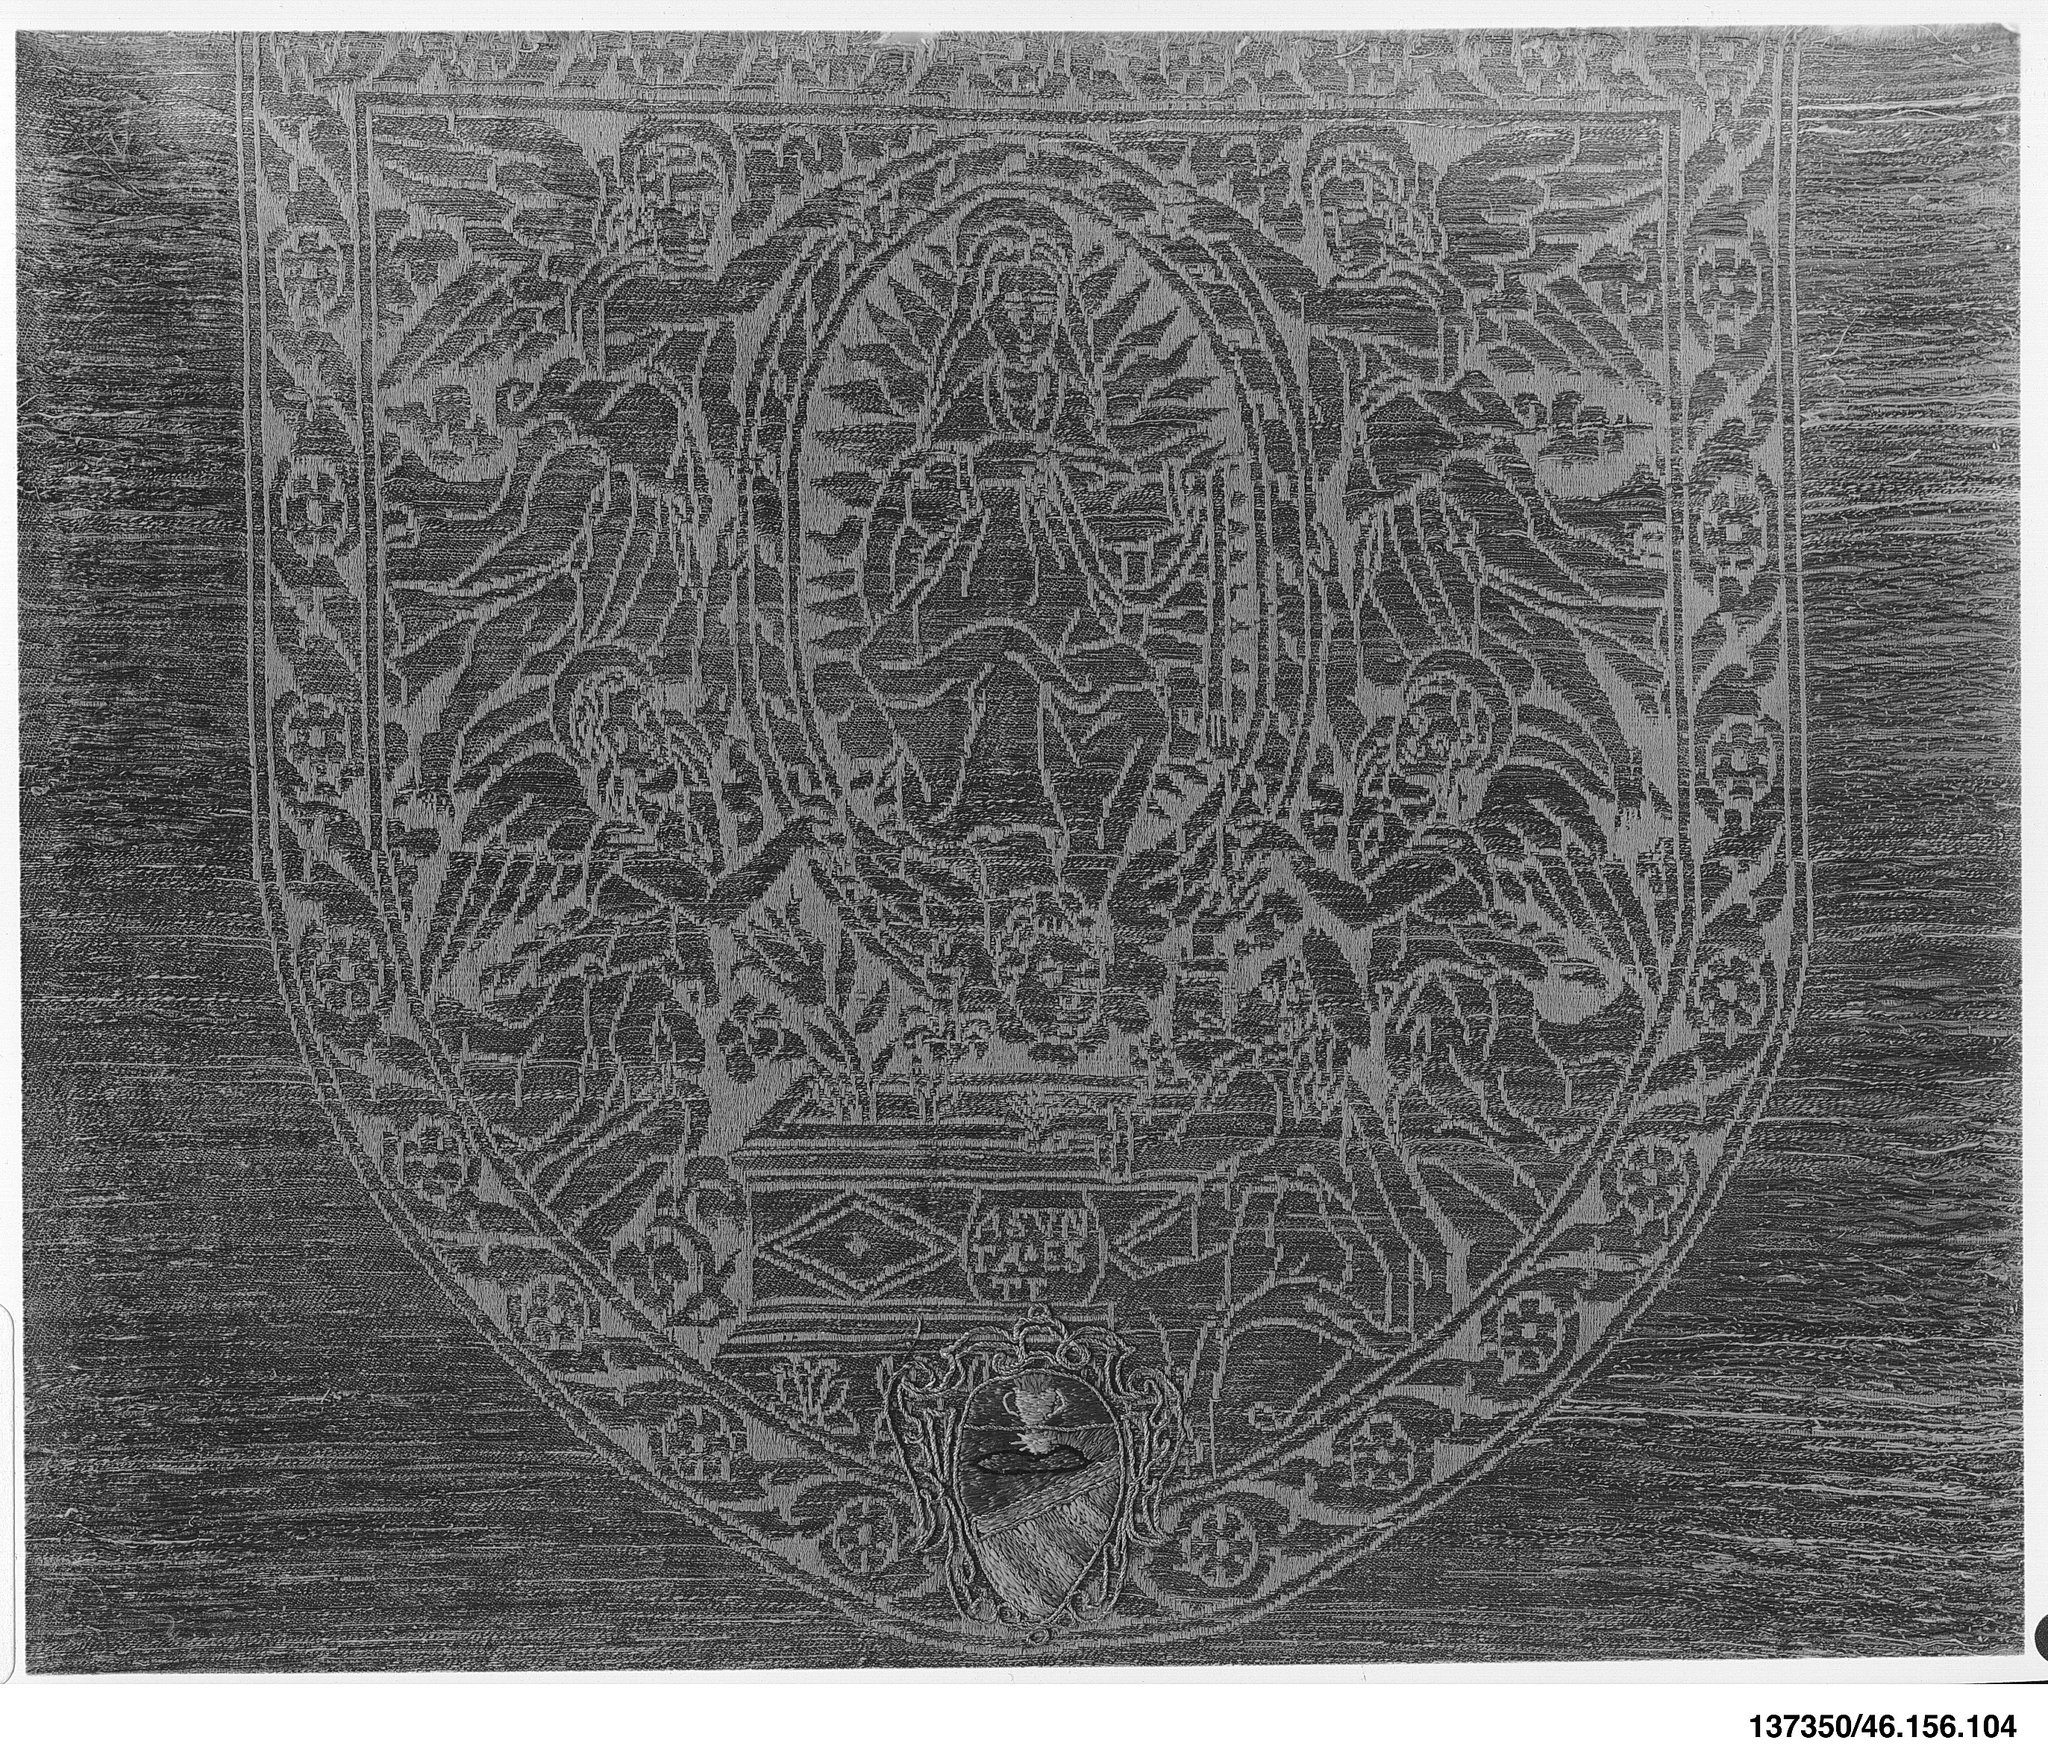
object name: hood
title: Hood for a cope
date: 1467-1533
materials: linen, metal thread, silk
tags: angels,virgin mary